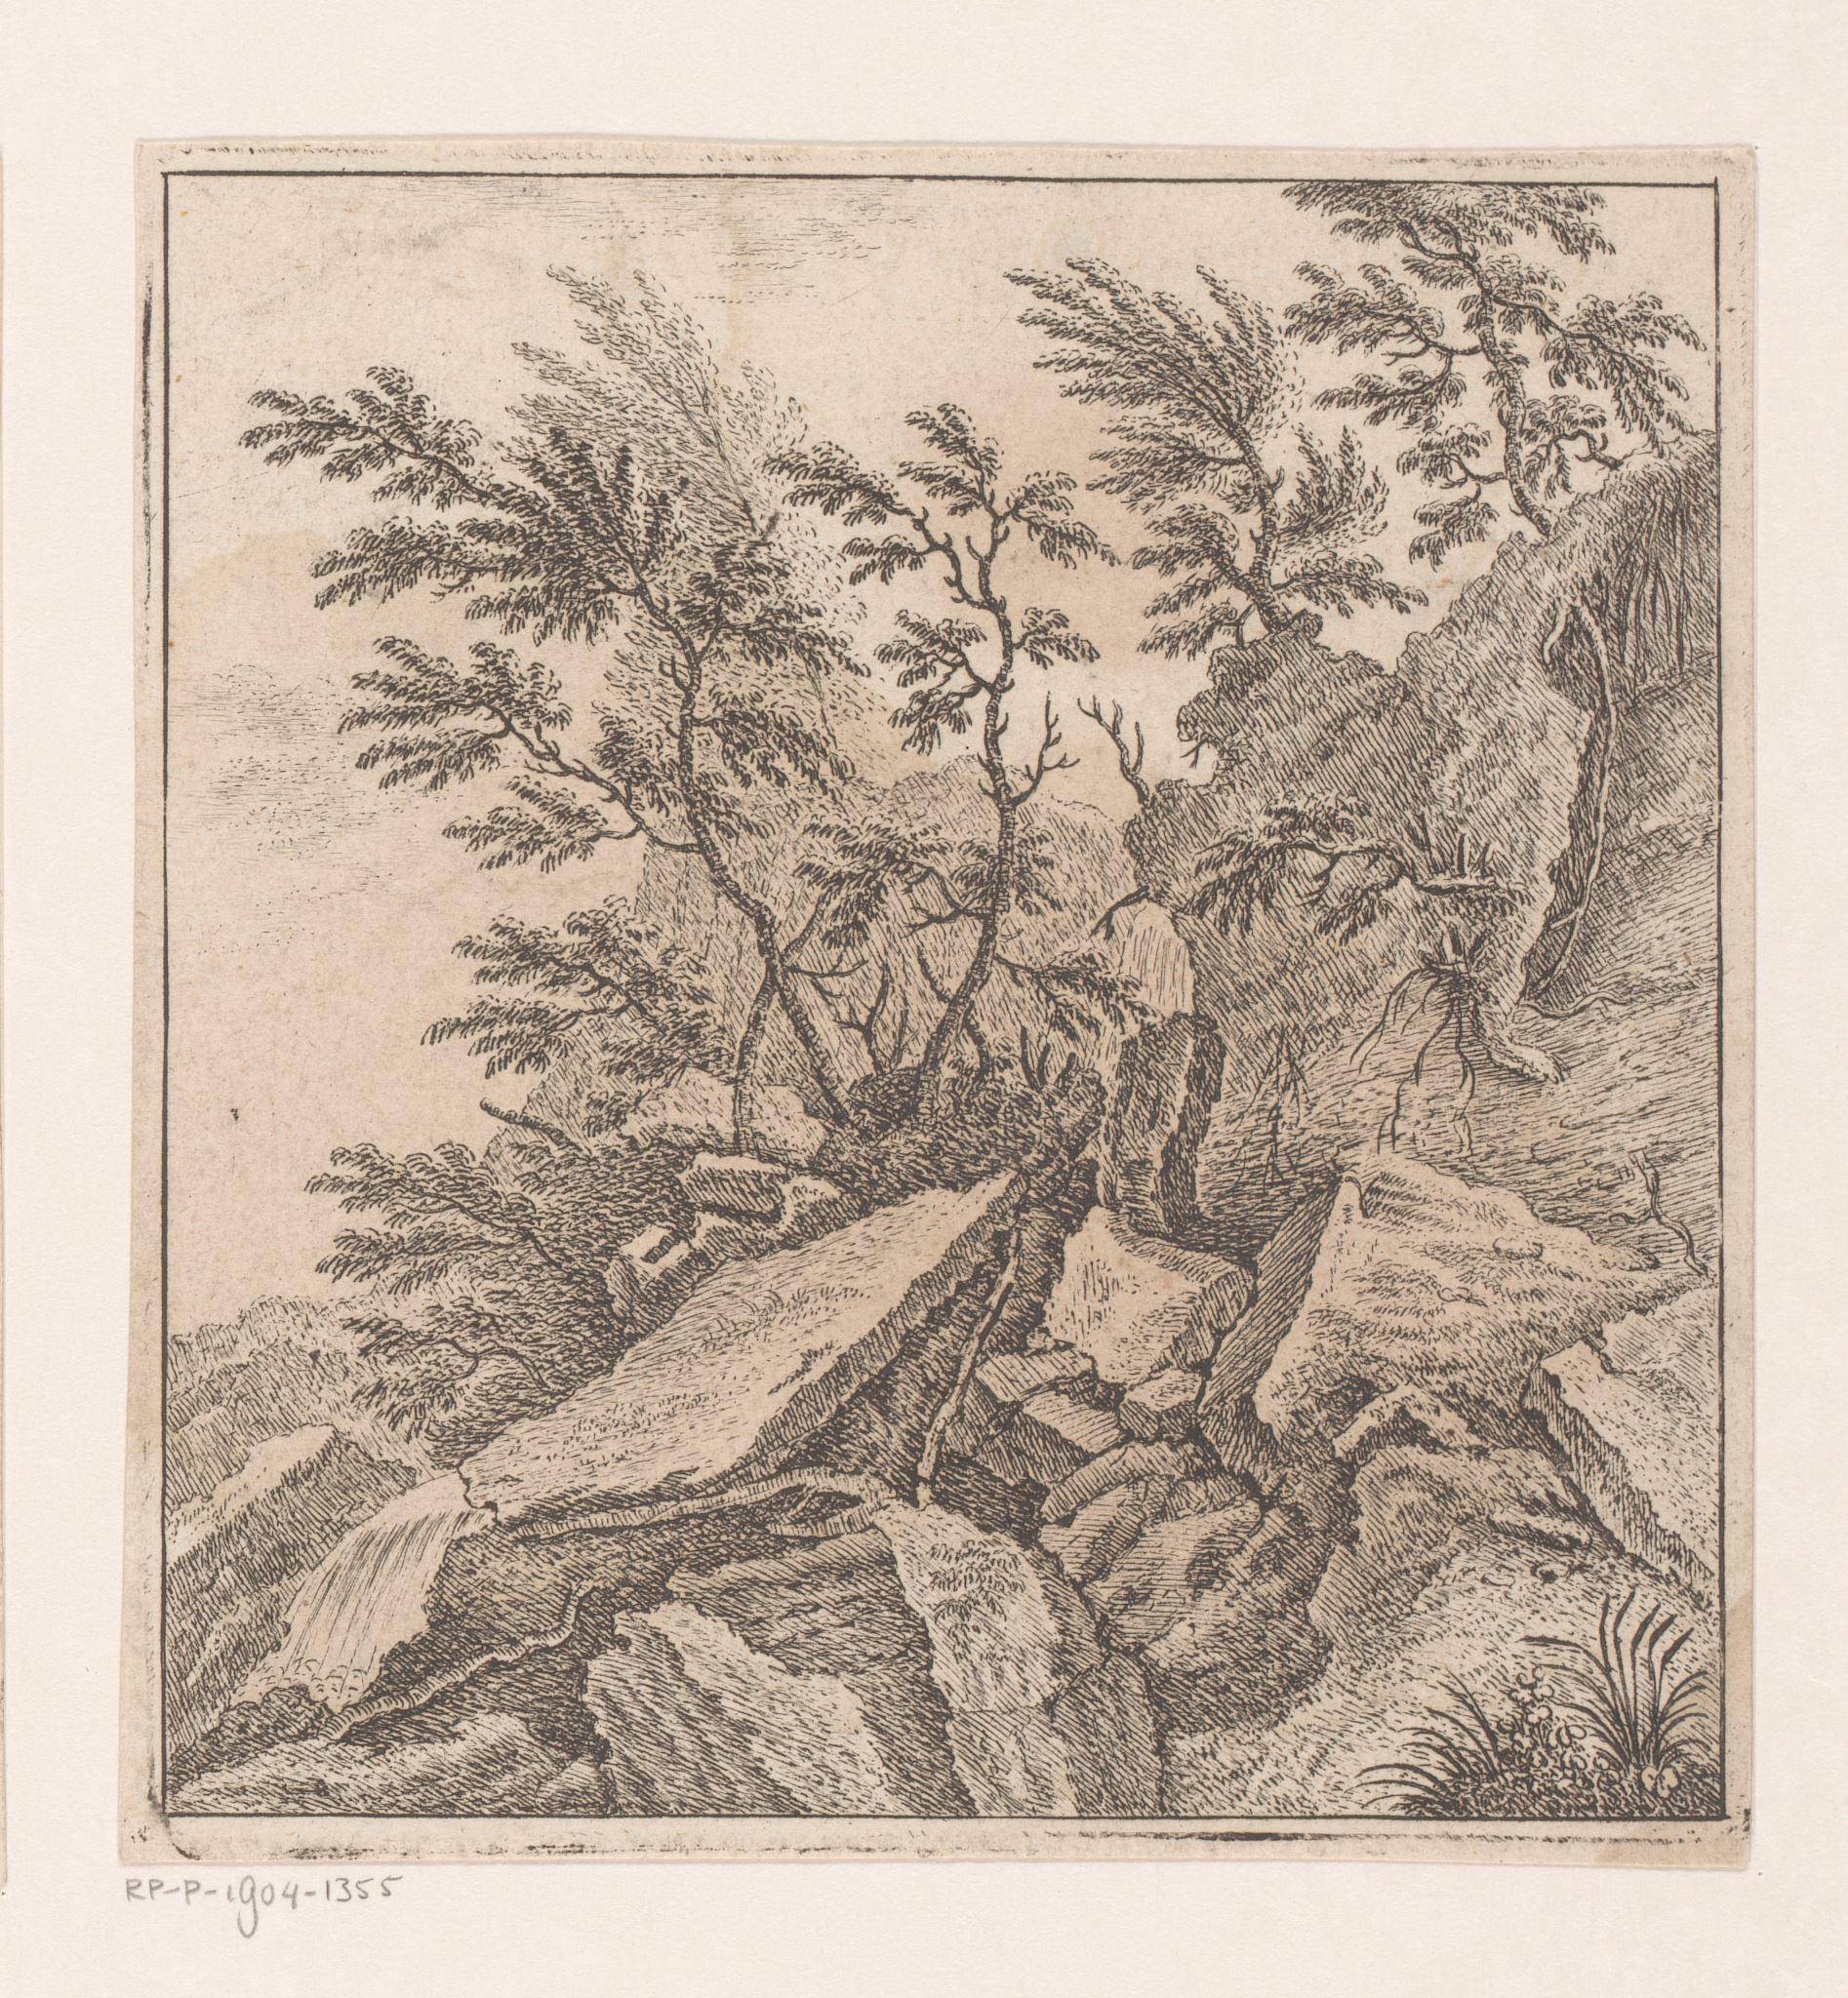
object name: print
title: Rotspartij met een waterval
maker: johann caspar ulinger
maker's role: painter, print maker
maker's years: 1703-1768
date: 1713-1768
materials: paper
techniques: etching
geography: switzerland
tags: waterfall, rock-formations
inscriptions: collector's mark: Lugt 2228